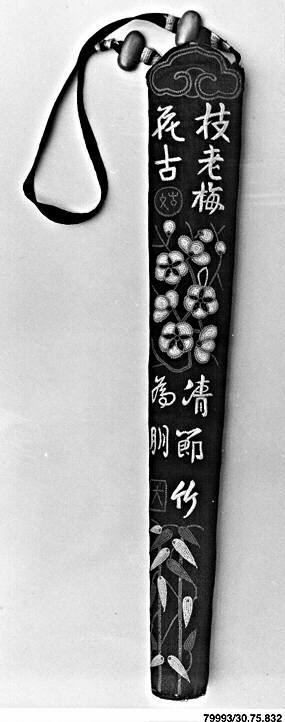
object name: fan holder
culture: chinese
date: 1701-1900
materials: silk